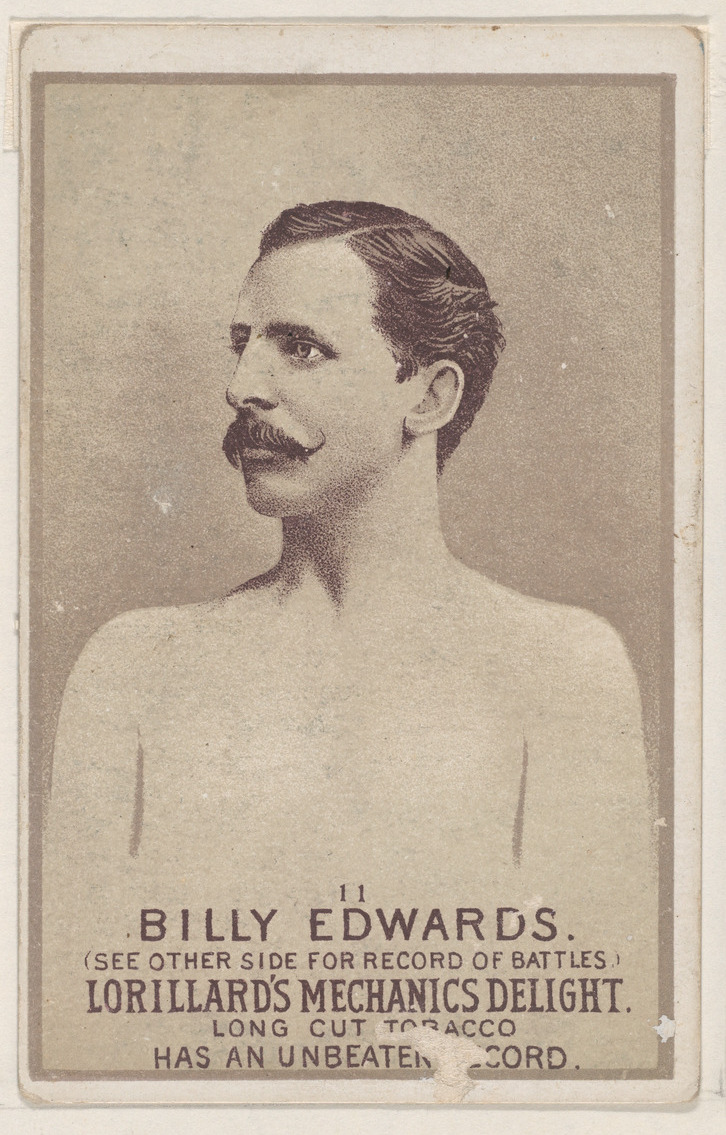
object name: print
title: Card 11, Billy Edwards, from the Prizefighters series (N269) issued by P. Lorillard Company to promote Mechanics Delight Long Cut Tobacco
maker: p. lorillard company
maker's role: publisher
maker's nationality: american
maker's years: 1760-2014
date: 1887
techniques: color lithograph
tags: men,portraits,boxing,athletes